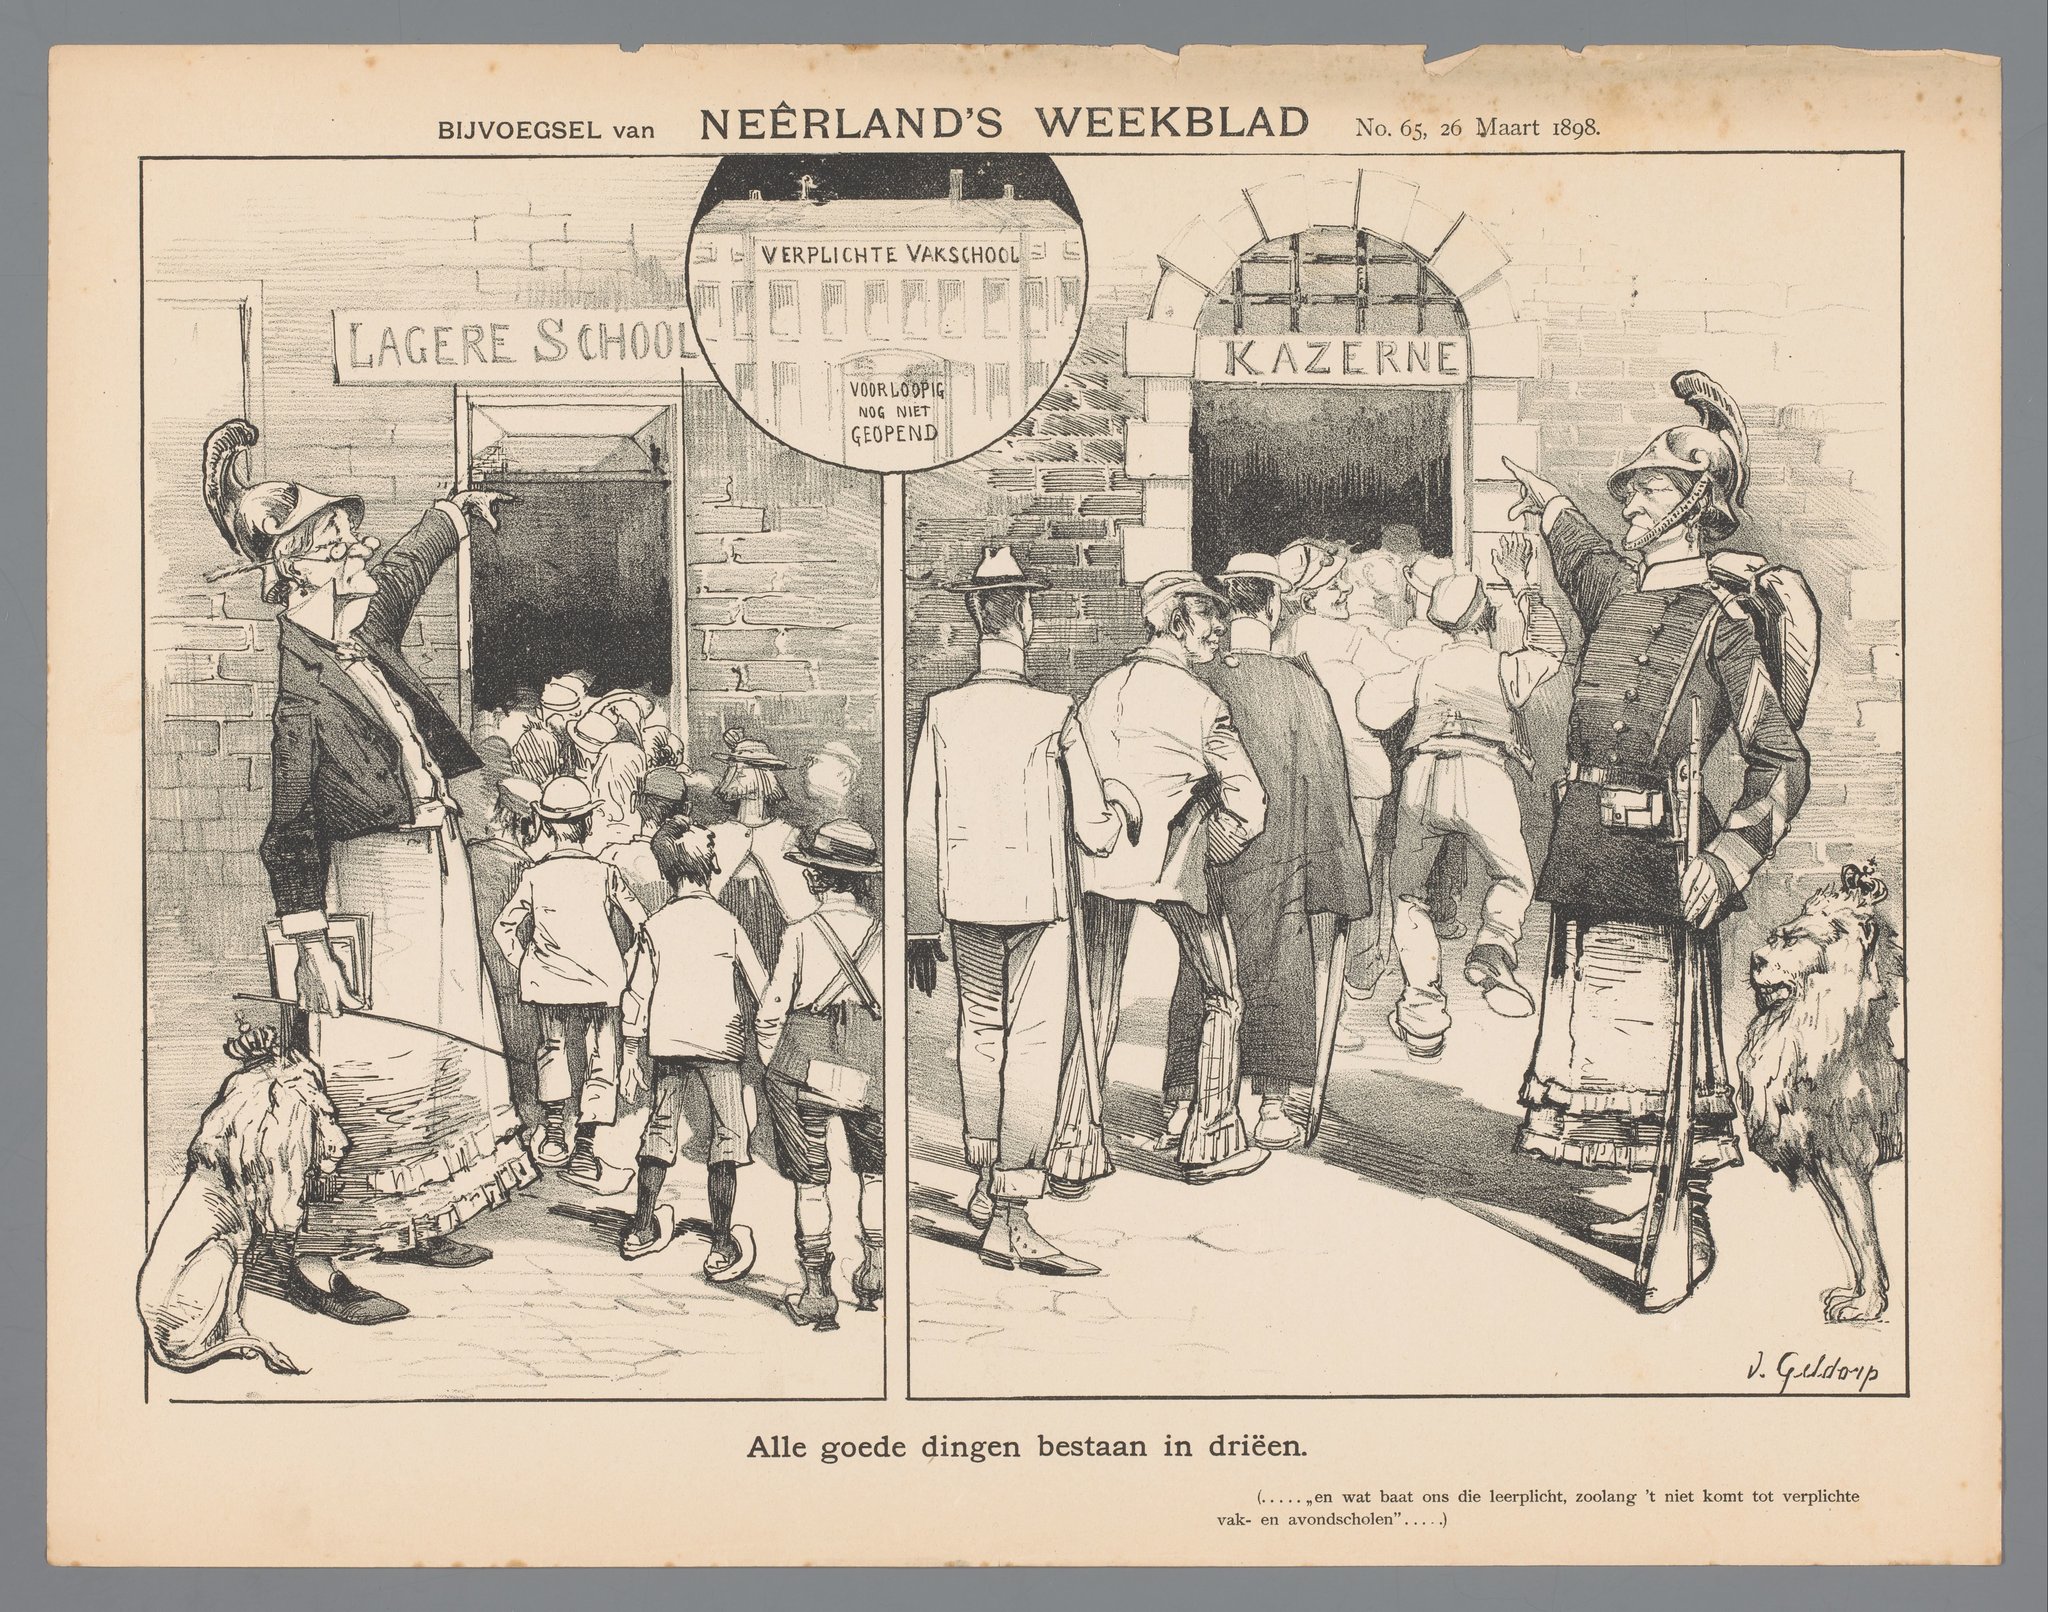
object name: cartoon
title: Alle goede dingen bestaan in driëen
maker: petrus van geldorp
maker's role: draughtsman, print maker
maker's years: 1872-1939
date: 1898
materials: paper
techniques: lithograph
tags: military service, going to school, political caricatures and satires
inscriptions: date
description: Prent uit het bijvoegsel van: Neêrland’s Weekblad, nr. 65, 26 maart 1898.